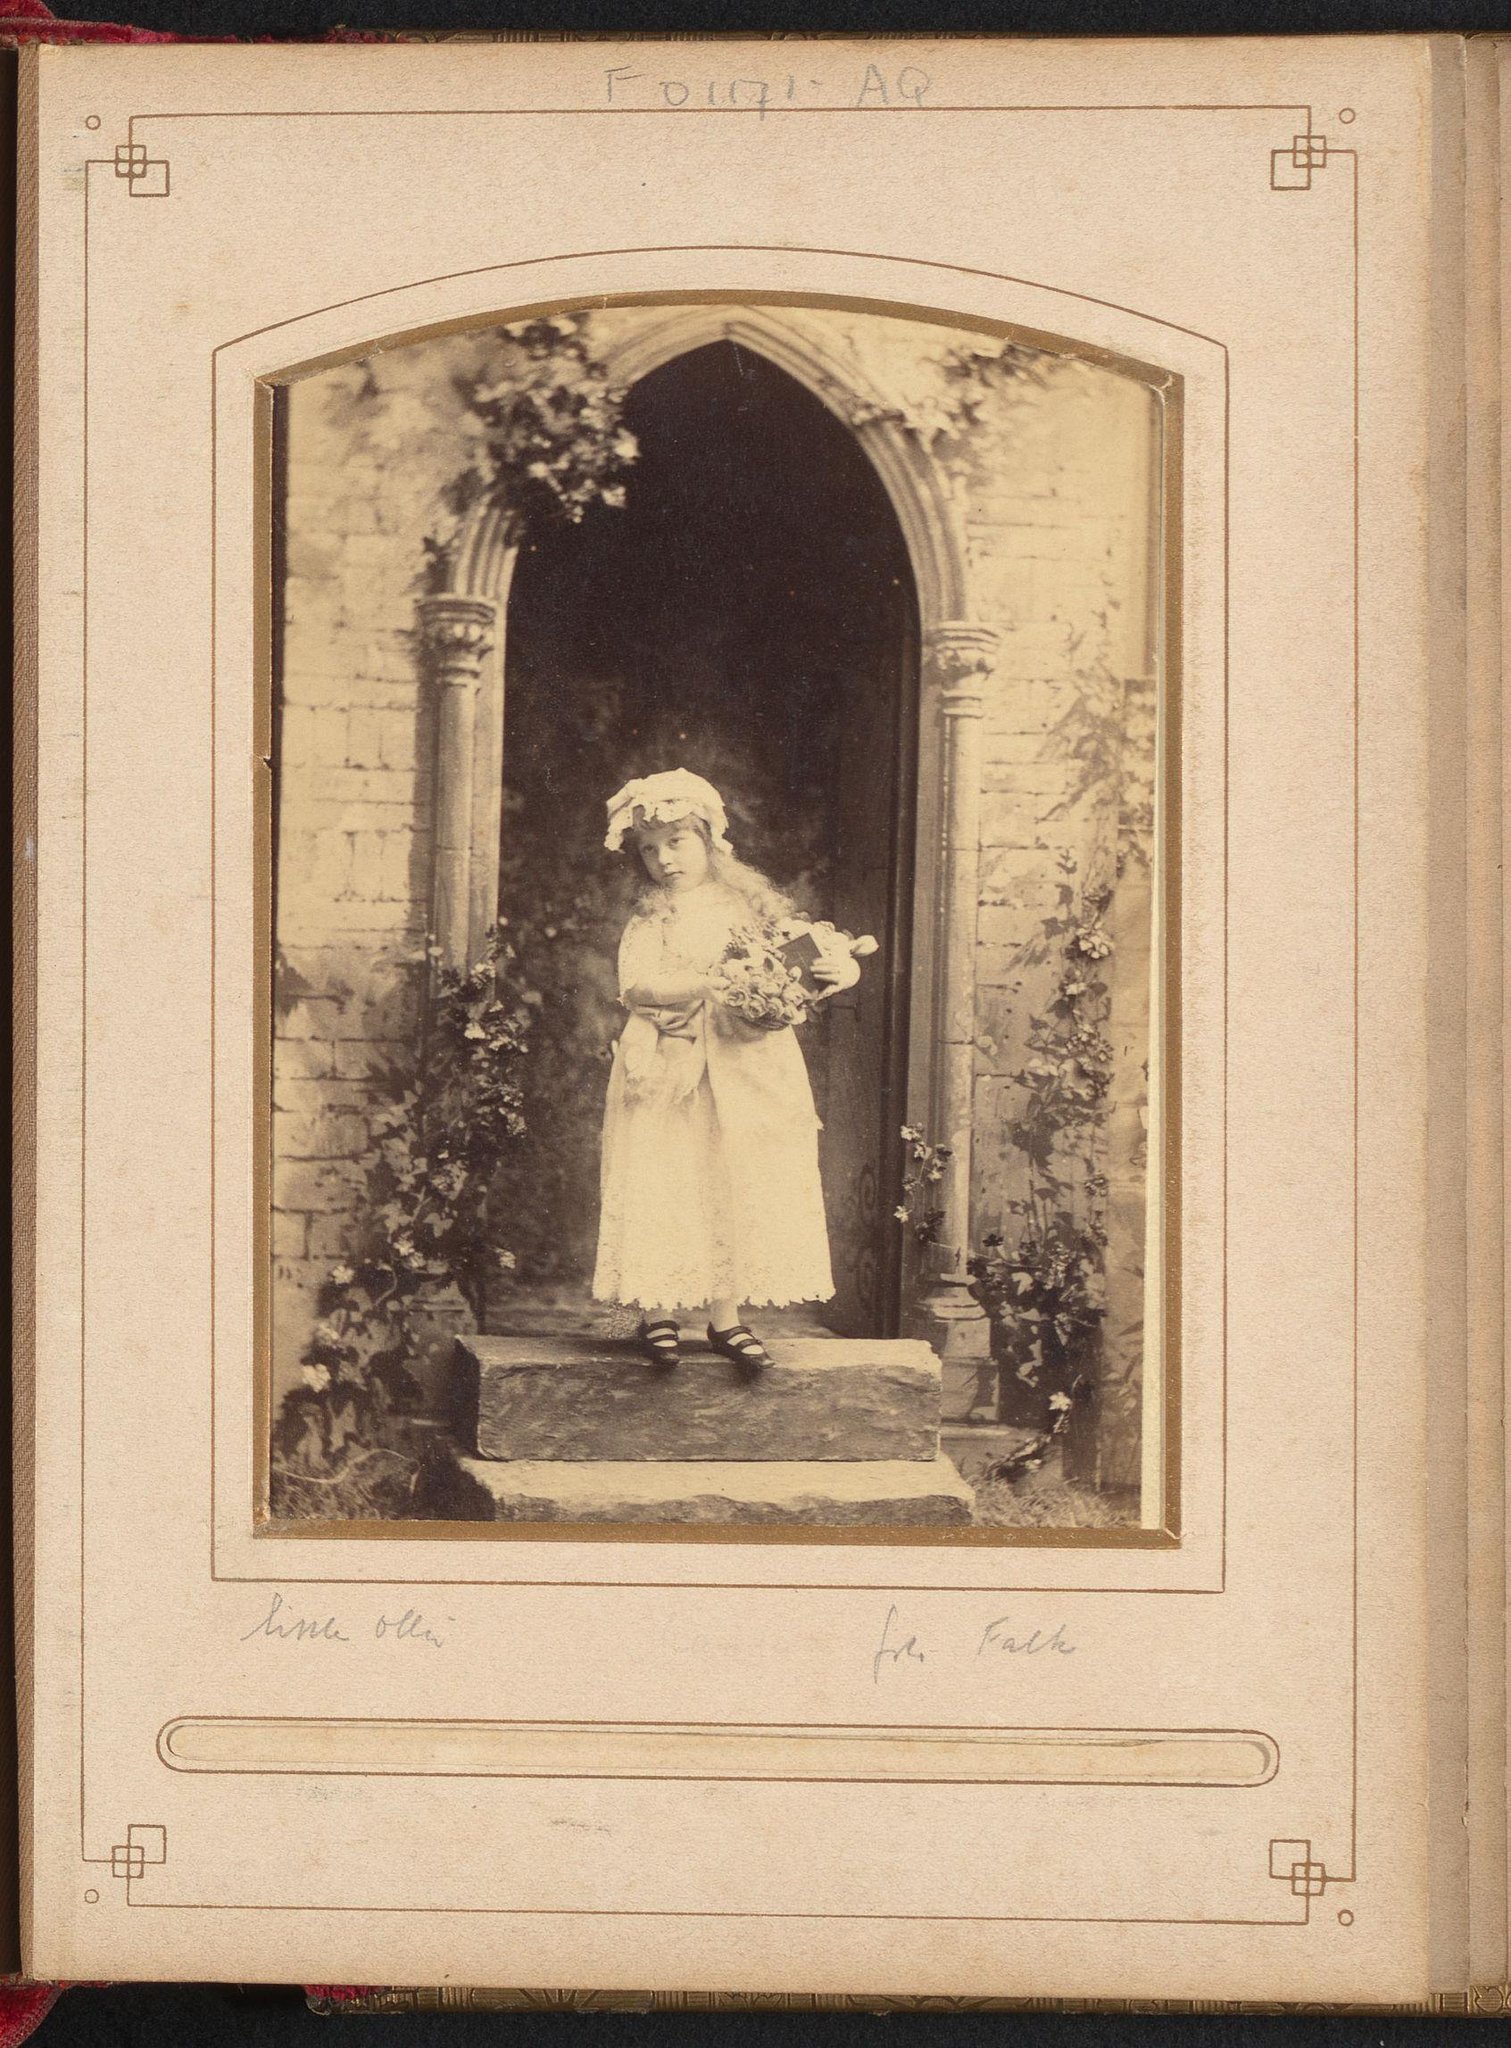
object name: photograph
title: Portret van een meisje met bloemen en bijbel in kerkportaal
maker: benjamin joseph falk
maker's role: fotograaf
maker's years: 1853-1925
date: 1870-1900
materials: cardboard, photographic support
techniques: albumen print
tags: parts of church exterior and annexes: portal, girl (child between toddler and youth)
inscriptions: number: ‘3582/ 6073 [...]’, name: ‘Falk 949 Broadway, N.Y.’, retailer's mark: ‘Boke- Muziek en Kunsthandel/ van/ L.D.C. van Dobben/Langestraat B 105/ Alkmaar’